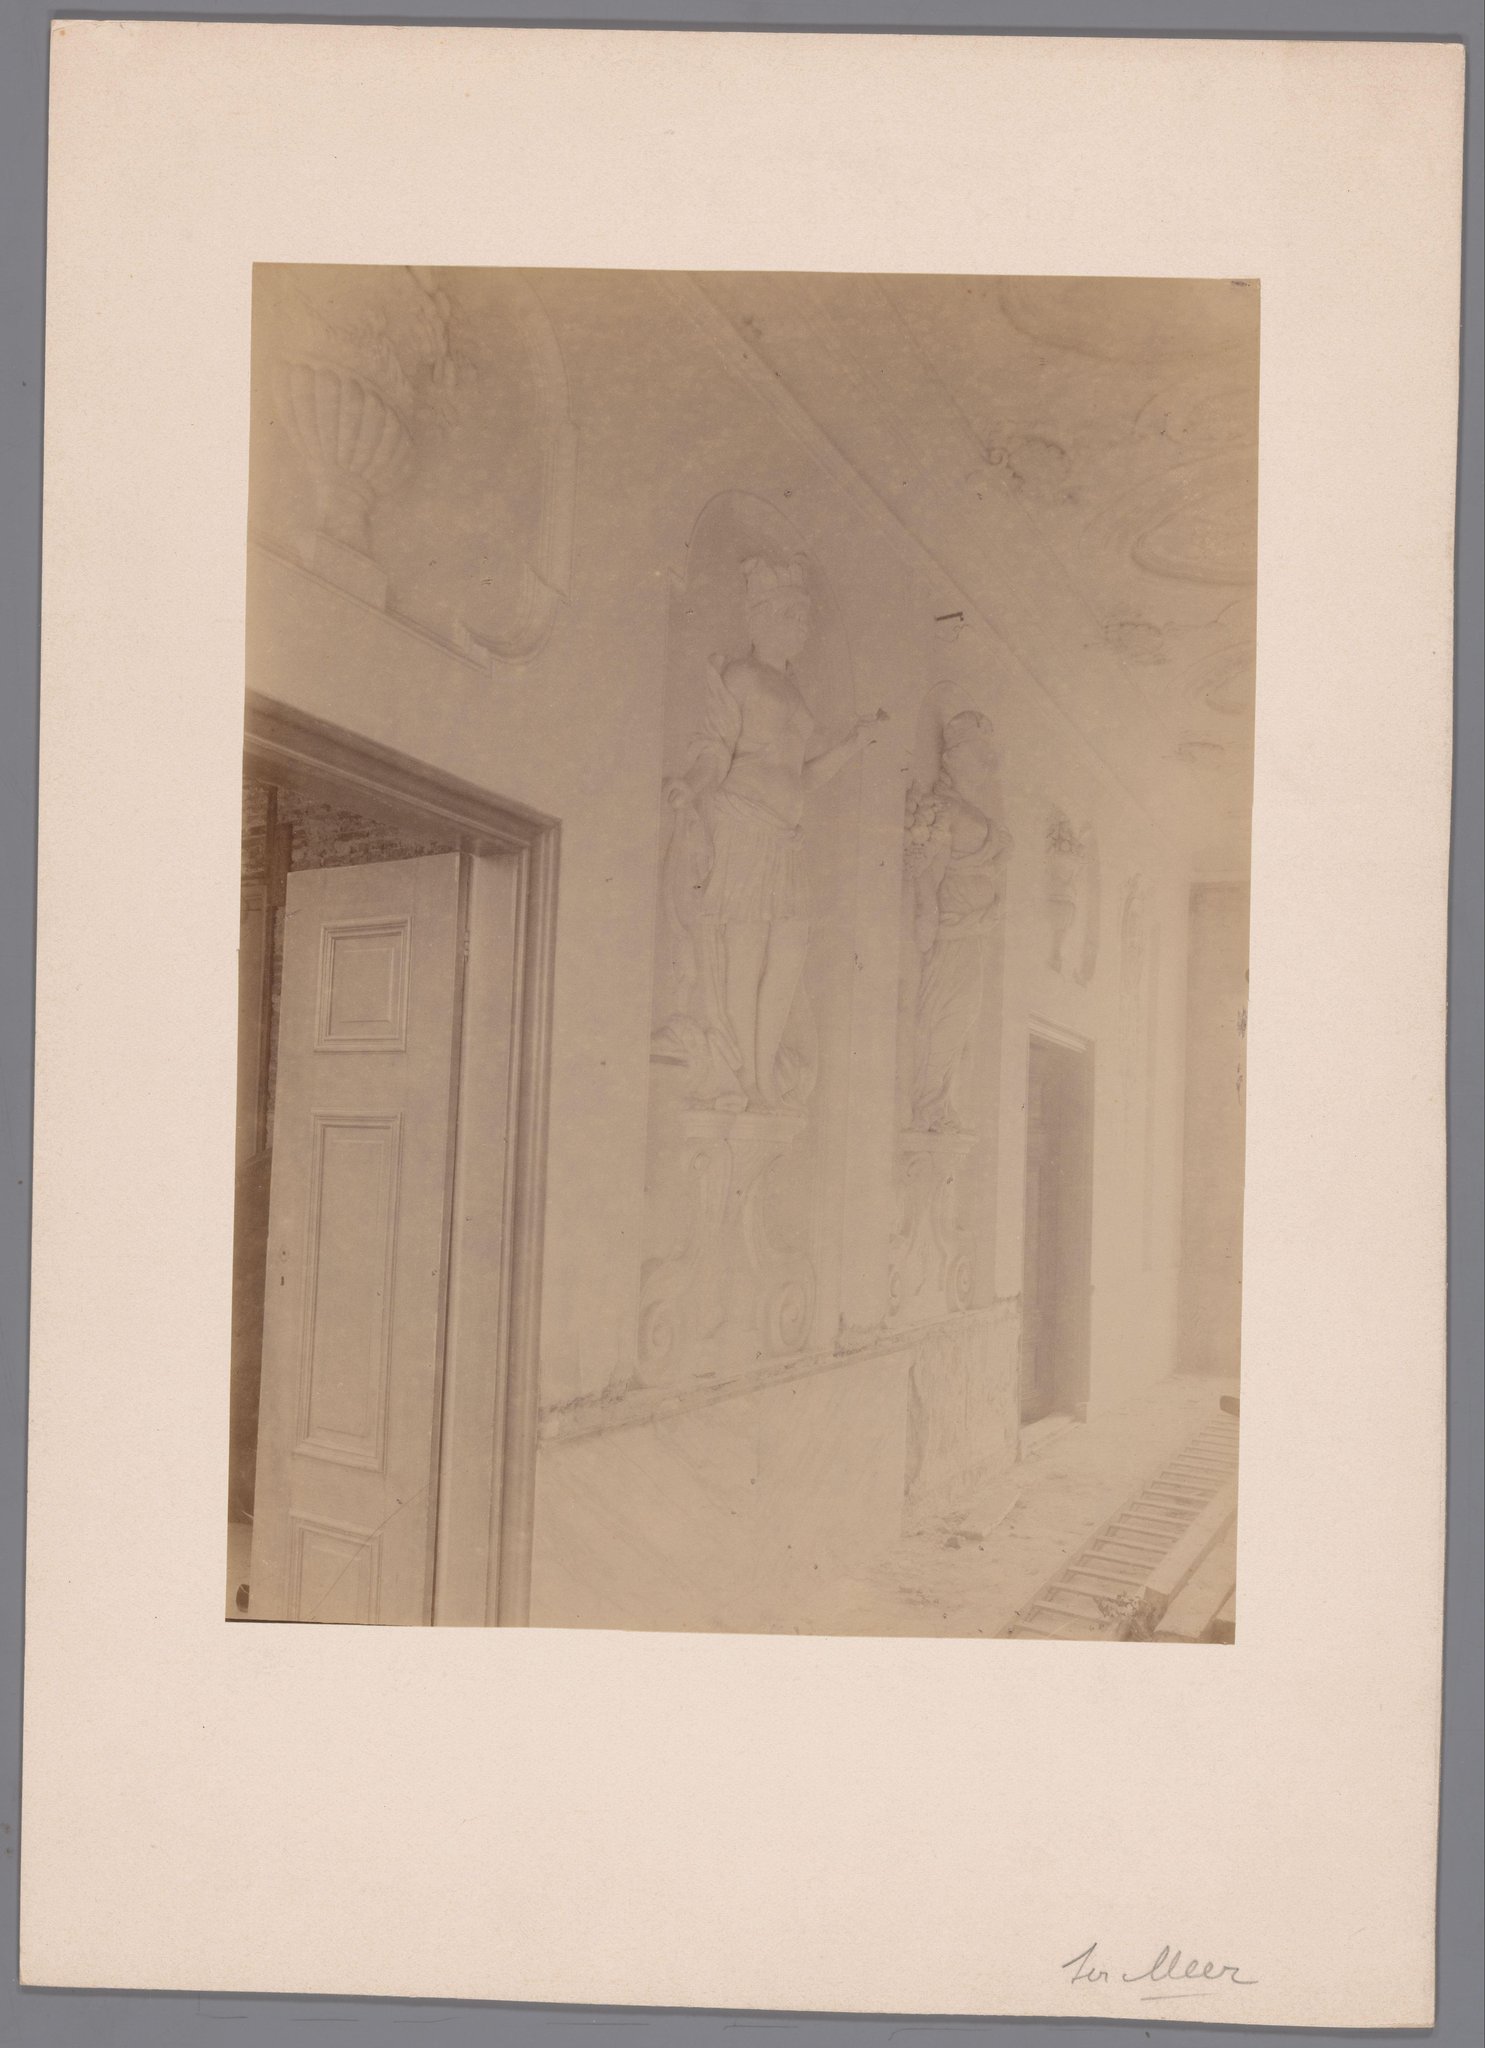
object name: photograph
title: Gang met stucwerk in het Huis ter Meer te Maarssen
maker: anoniem (monumentenzorg)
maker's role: fotograaf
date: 1903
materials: cardboard, photographic support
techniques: albumen print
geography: huis ter meer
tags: piece of sculpture, reproduction of a piece of sculpture, vestibule, hall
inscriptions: annotation: ‘Ter Meer’, annotation: ‘Maarssen (U.)/ Huis ter Meer/ gesloopt Aug 1903’